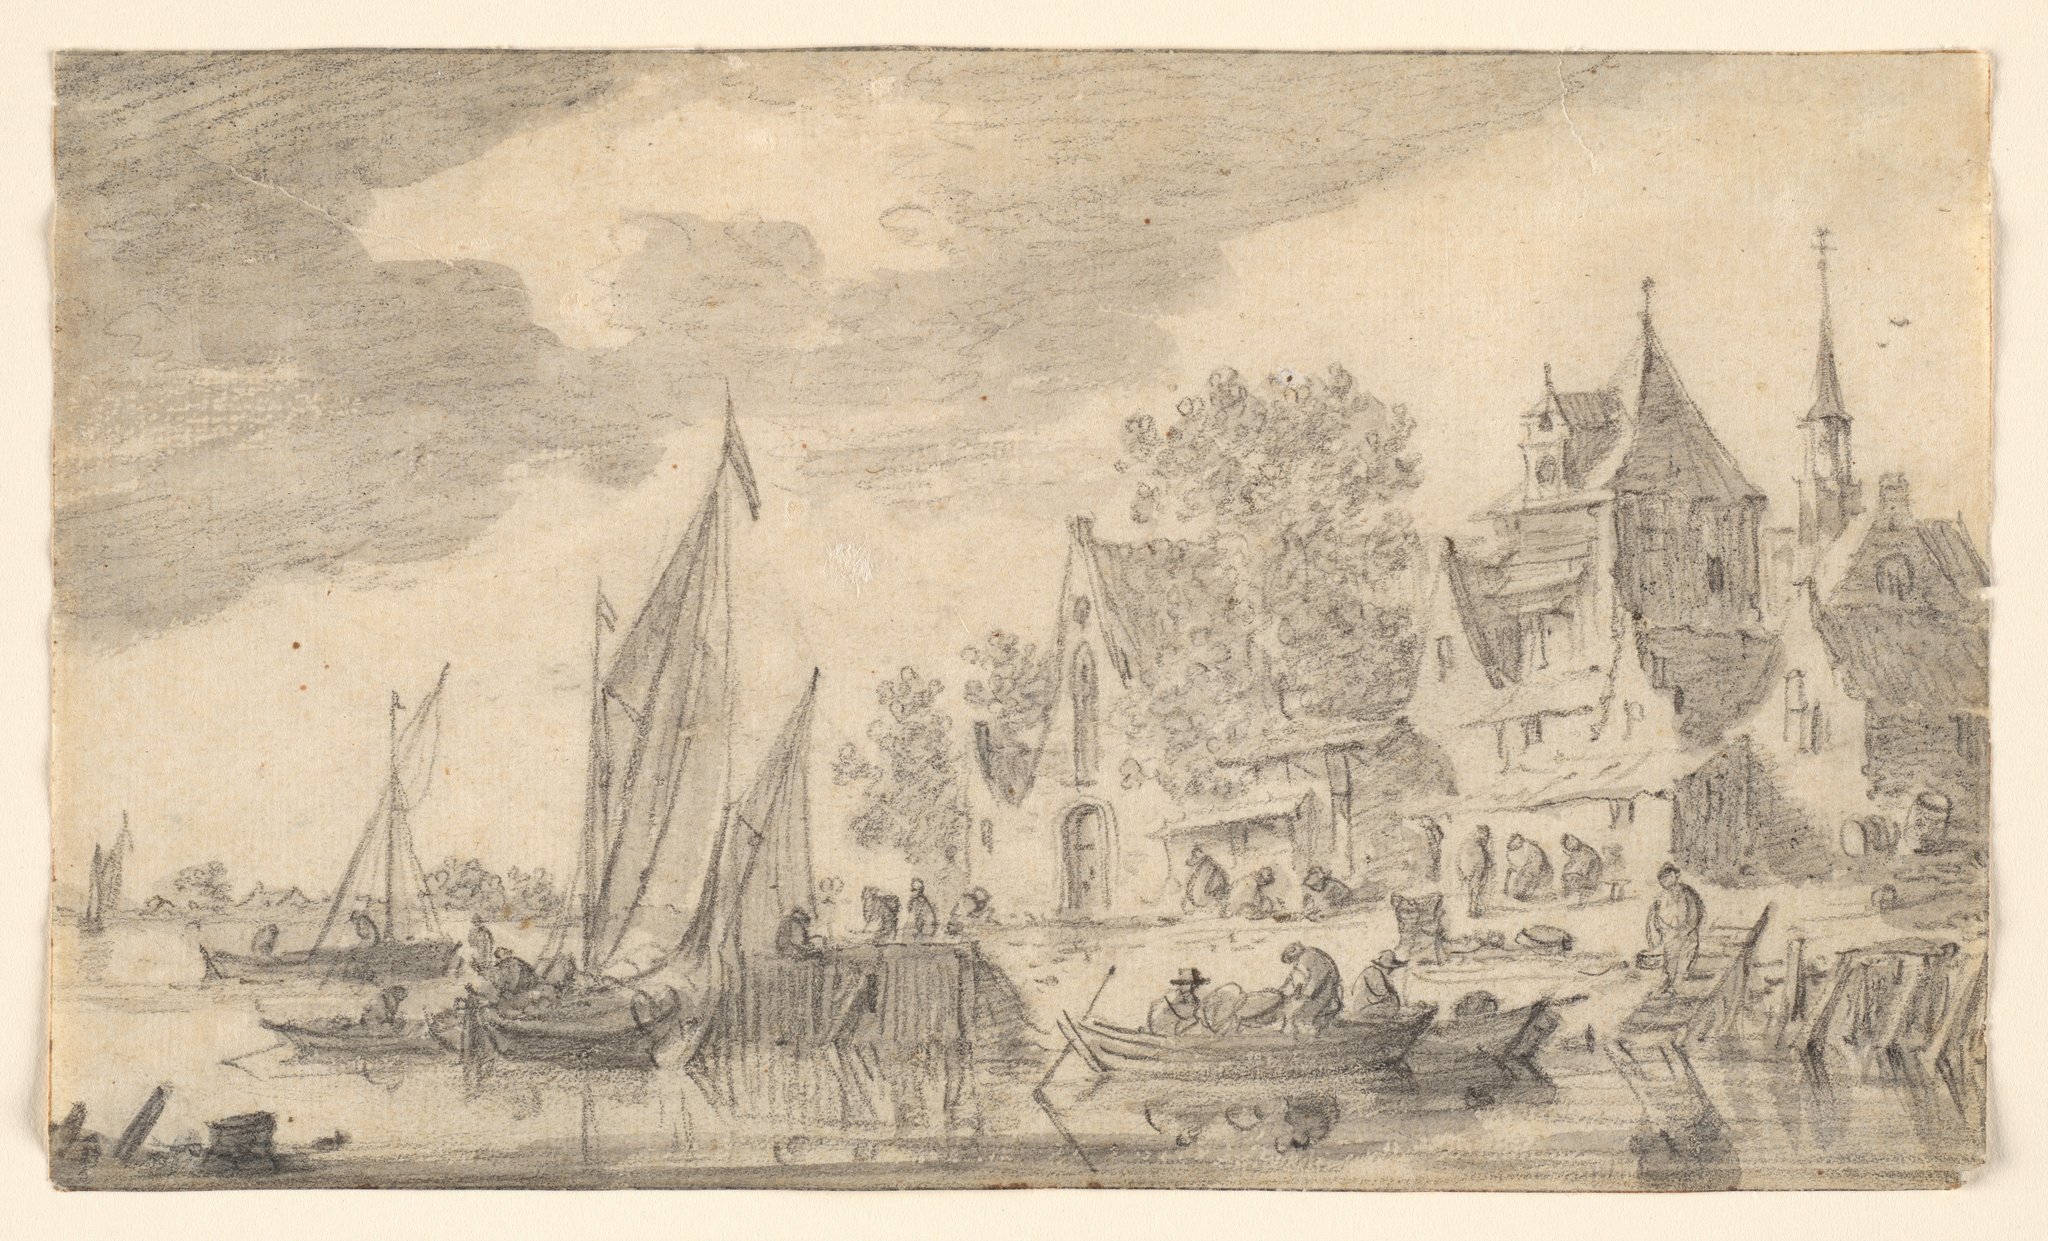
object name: drawing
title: Landing Place by a Town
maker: jan van goyen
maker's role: artist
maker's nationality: dutch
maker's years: 1596-1656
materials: chalk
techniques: wash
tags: towns,boats